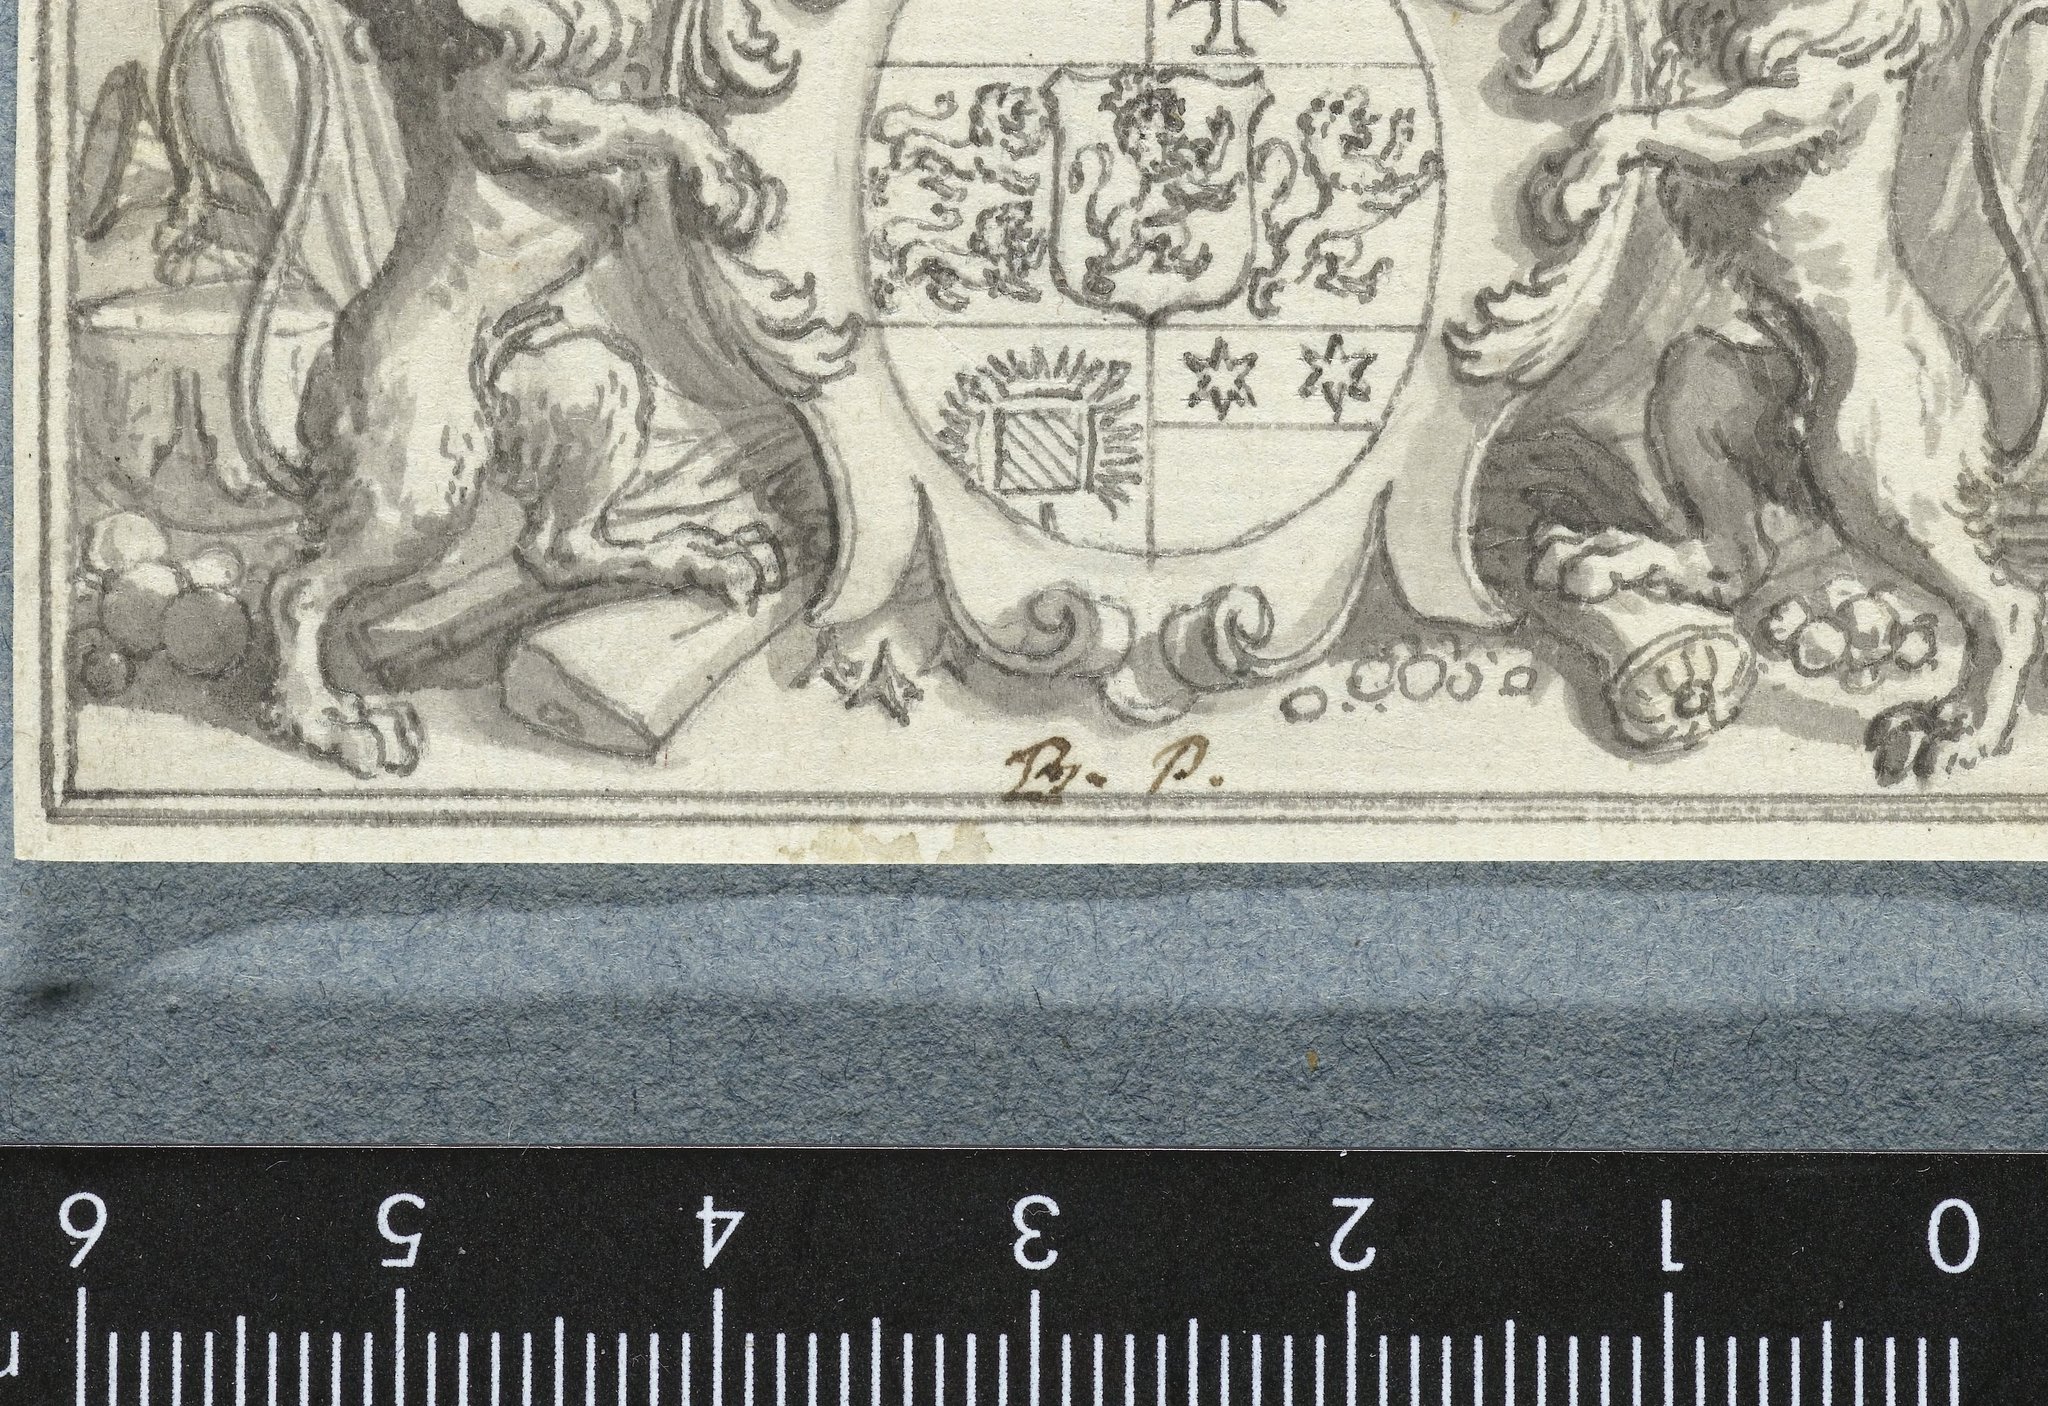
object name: drawing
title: Wapen van de landgraven van Hessen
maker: bernard picart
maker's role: draughtsman, print maker, publisher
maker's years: 1673-1733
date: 1683-1733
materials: ink, paper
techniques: brush, pen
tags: armorial bearing, heraldry